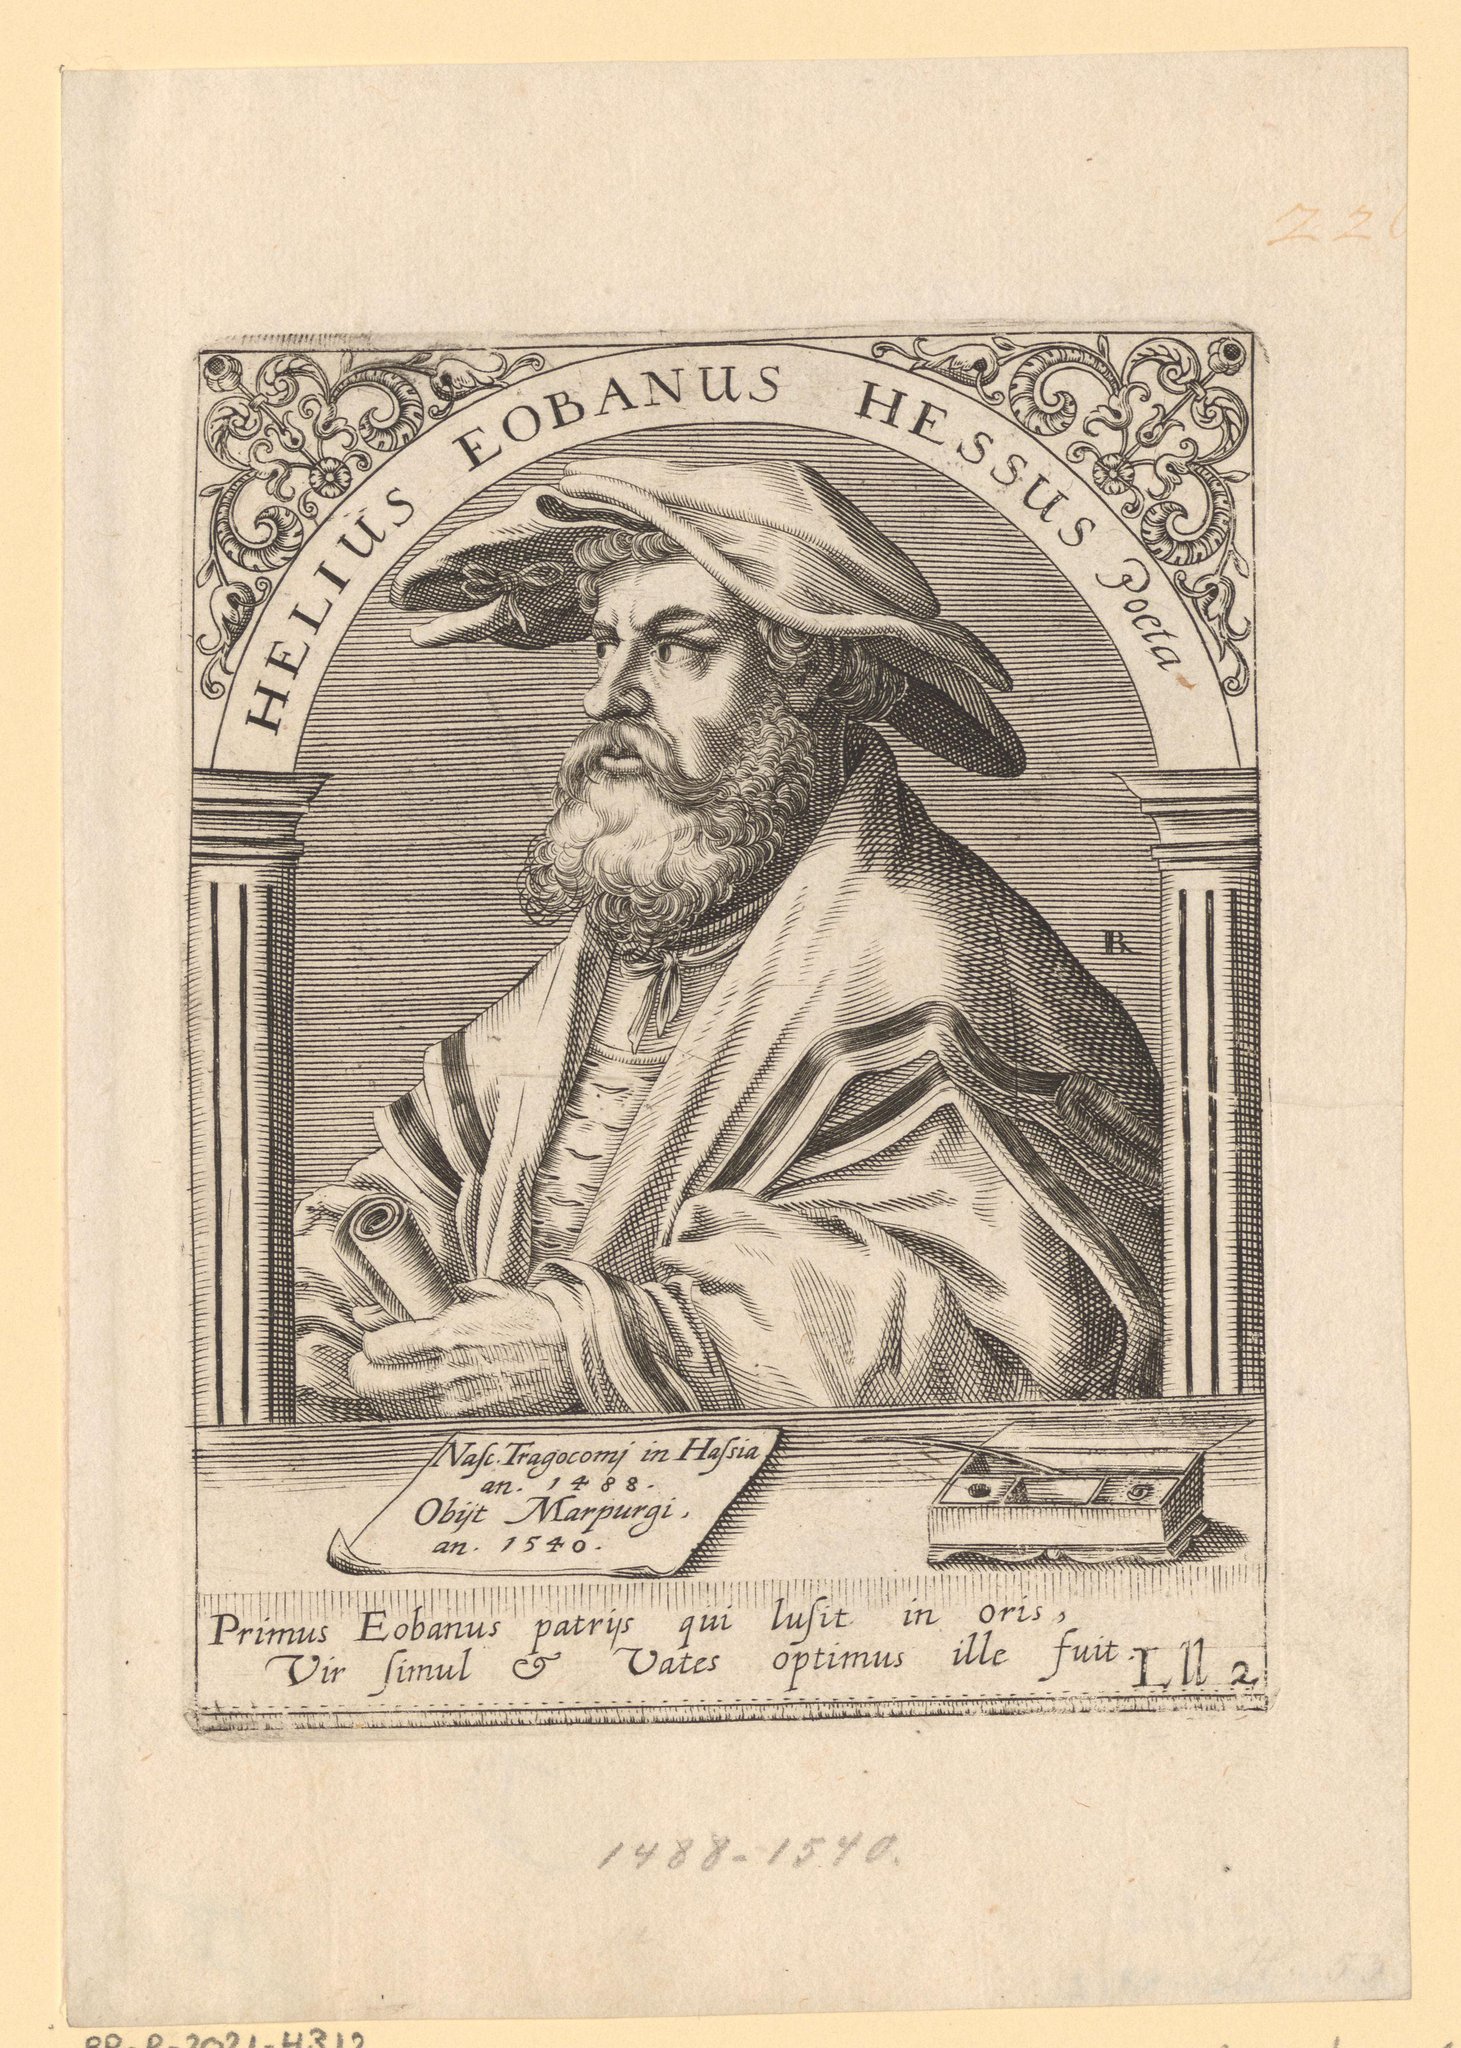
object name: print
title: Portret van Helius Eobanus Hessus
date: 1597-1598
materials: paper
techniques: engraving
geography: frankfurt am main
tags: helius eobanus hessus, historical persons, writer, poet, author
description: Prent uit: Bibliotheca chalcographica. Frankfurt am Main: Johannes Ammon, 1650. Prent voor het eerst (zonder nummering) verschenen in: Boissard, Jean Jacques. Icones quinquaginta virorum illustrium doctrina & eruditione praestantium ad vivum effictae. Frankfurt am Main: s.n., 1597-1598.